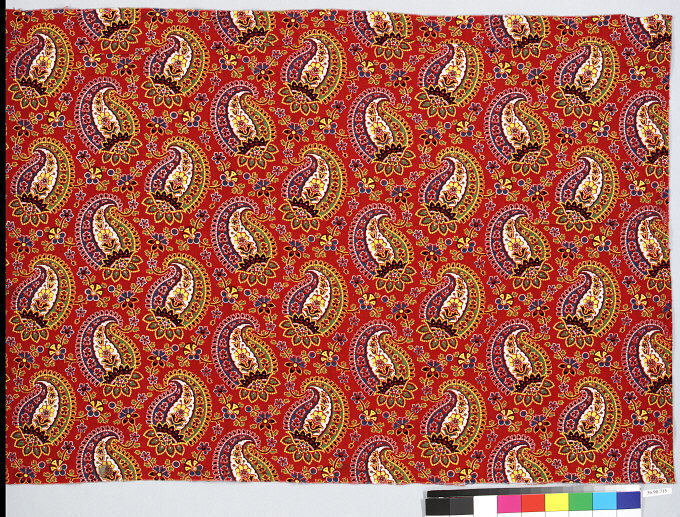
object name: piece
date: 1867-1900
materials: cotton